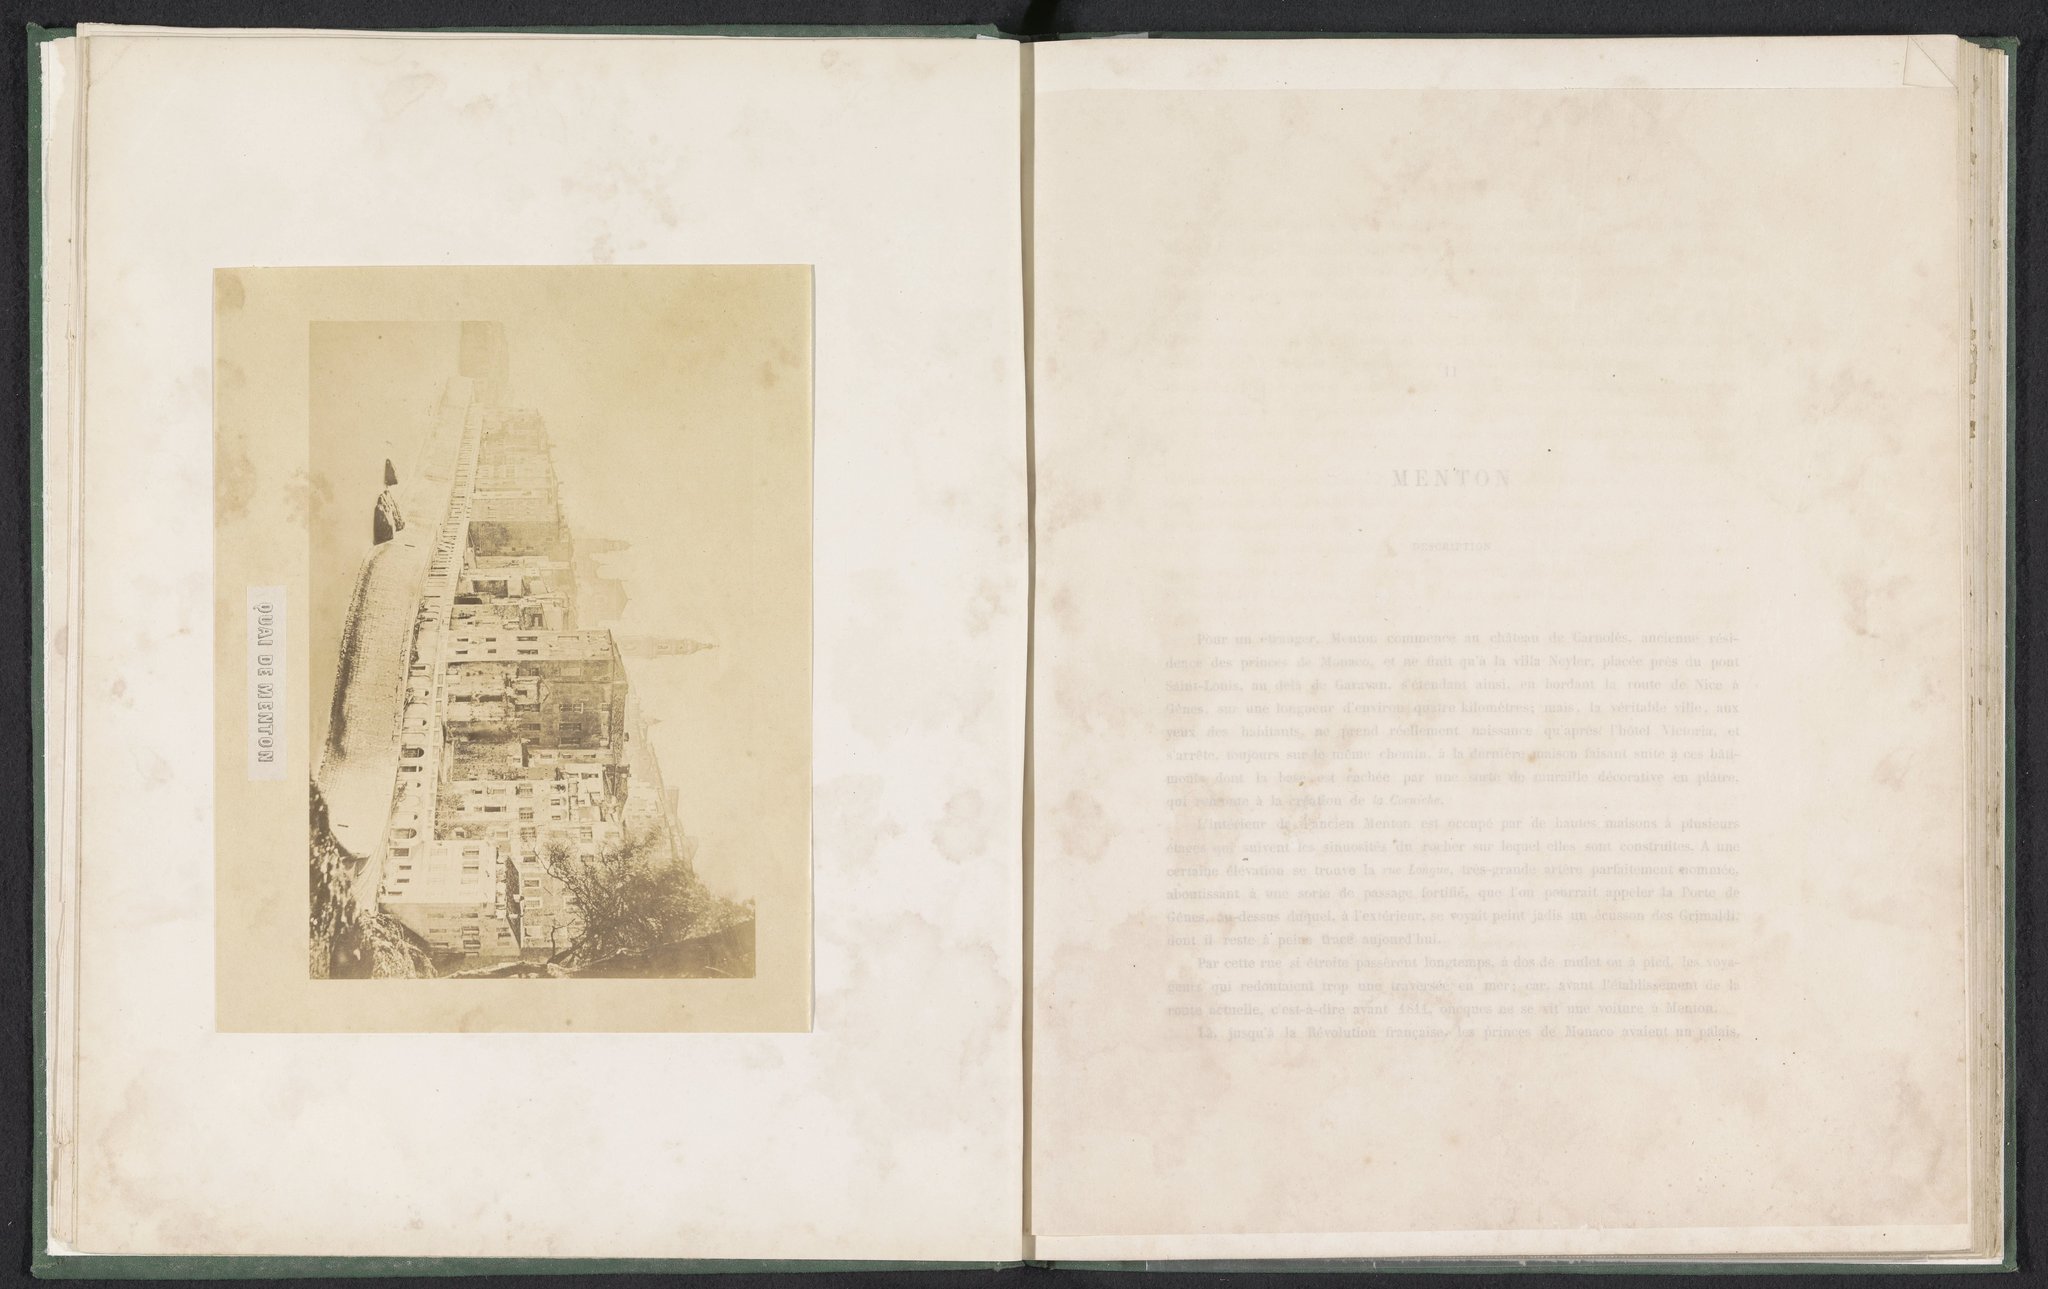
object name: photograph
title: Gezicht op de kade van Menton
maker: louis-alphonse davanne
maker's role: fotograaf, scheikundige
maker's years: 1824-1912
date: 1852-1862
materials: photographic support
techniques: albumen print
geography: menton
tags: façade (of house or building), quay